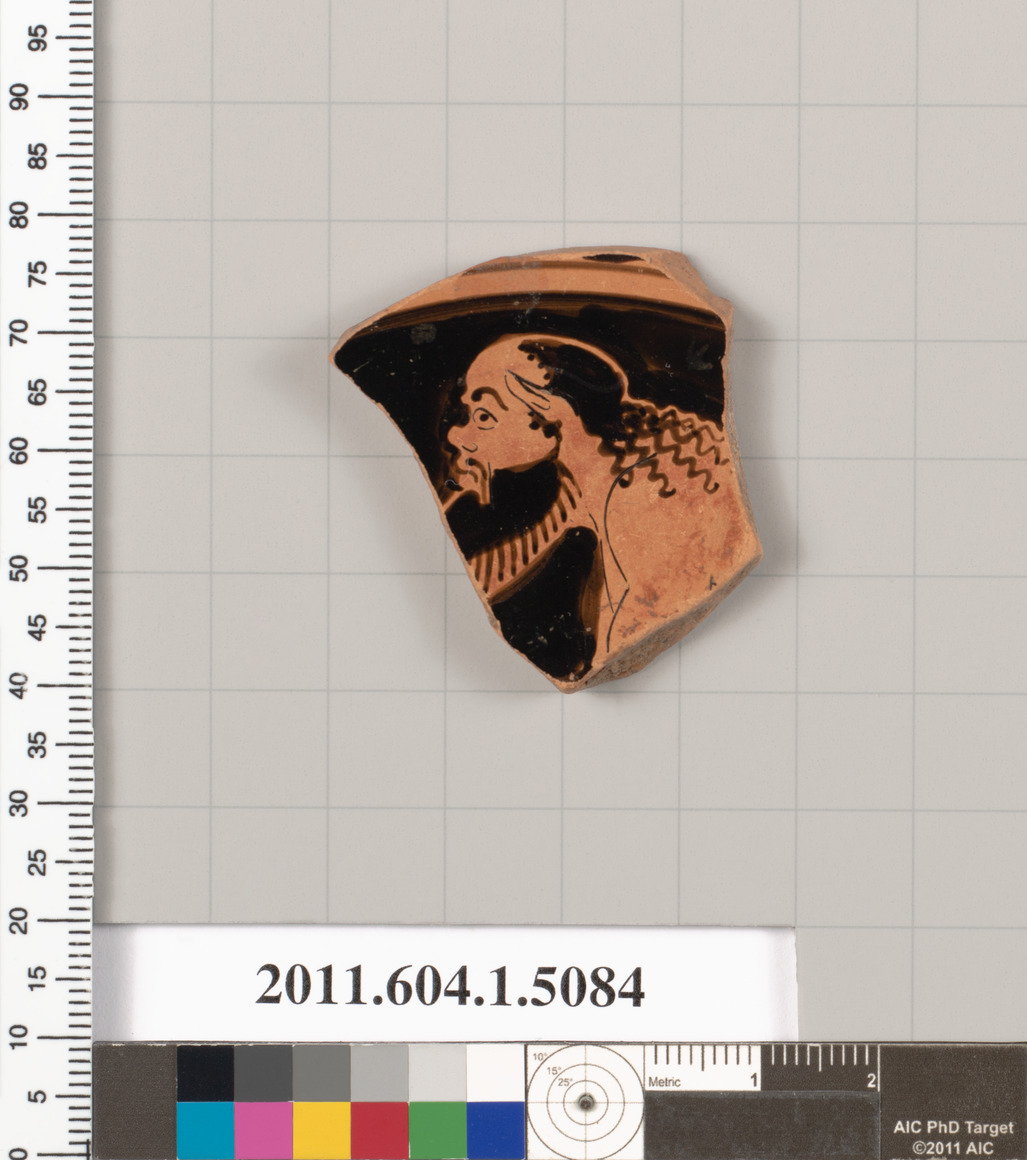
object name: kylix fragment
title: Terracotta fragment of a kylix (drinking cup)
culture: greek, attic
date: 475-451 BCE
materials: terracotta